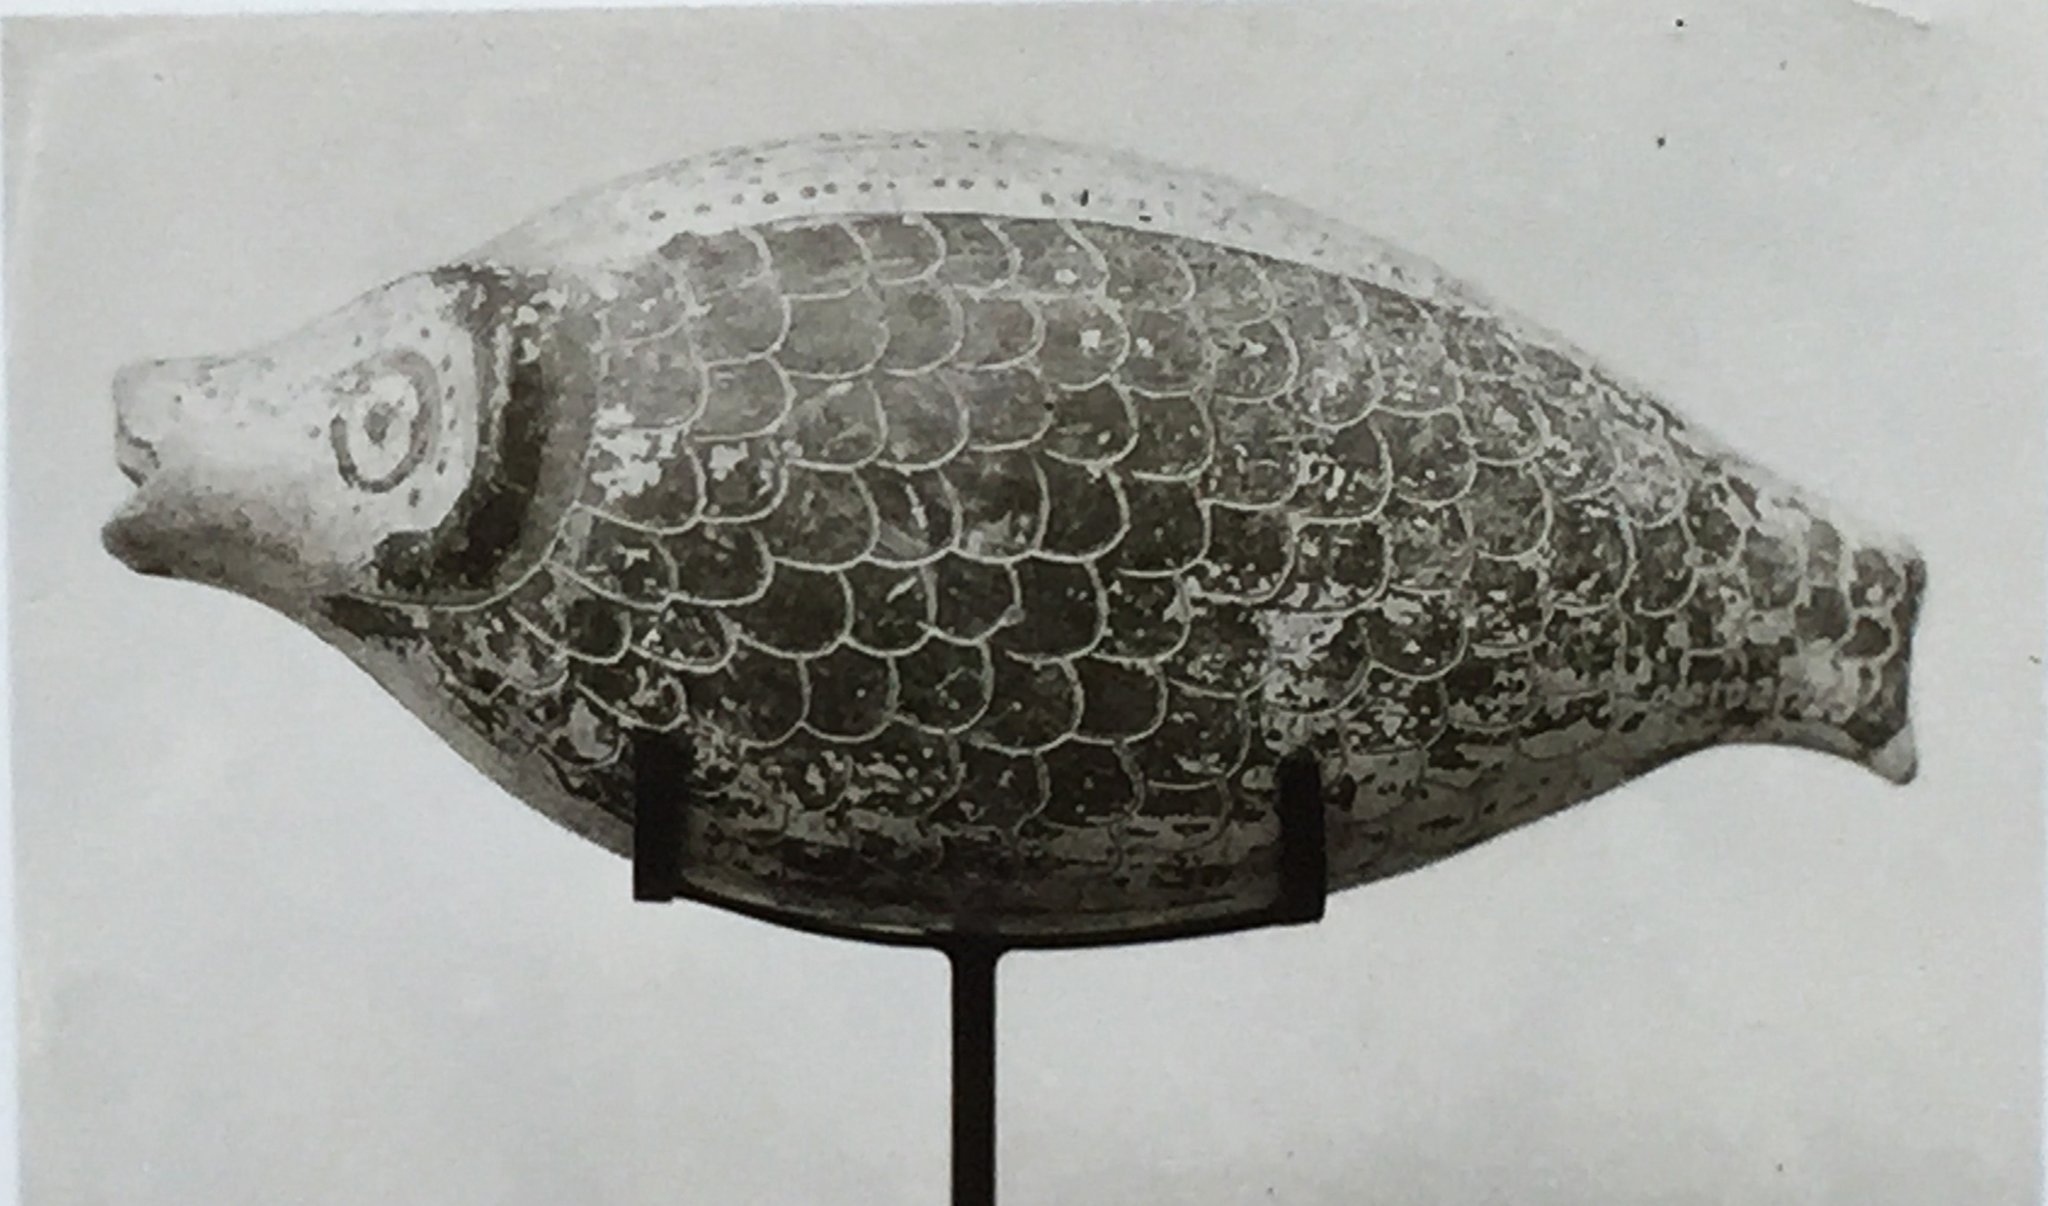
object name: vase in the form of a fish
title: Terracotta vase in the form of a fish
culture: greek, corinthian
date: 600-501 BCE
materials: terracotta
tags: fish